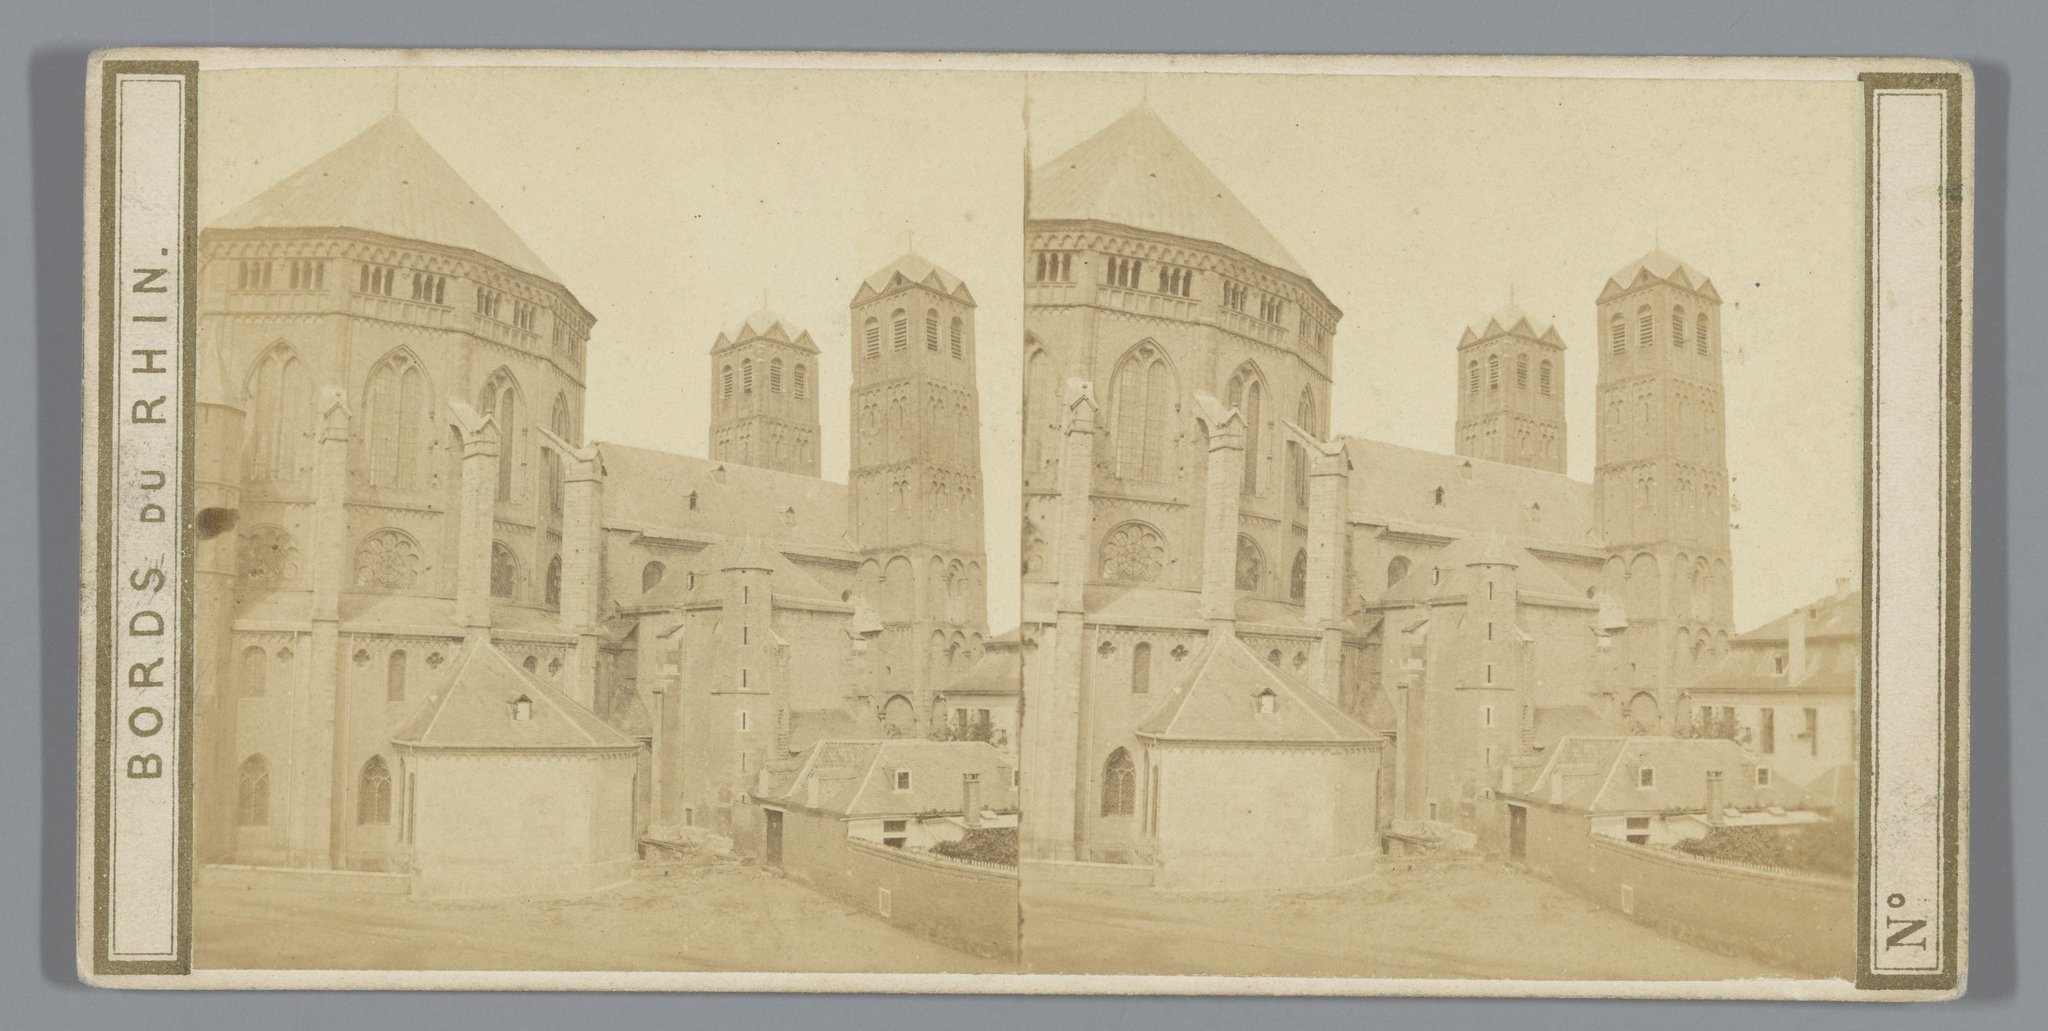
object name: stereograph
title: Bords du Rhin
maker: alexandre bertrand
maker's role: fotograaf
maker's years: 1822-1889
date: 1865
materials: cardboard, photographic support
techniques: albumen print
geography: cologne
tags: church (exterior), façade (of house or building)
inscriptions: number: ‘No 42’, inscription: ‘Eglise St Géreon a Aix-la-Chapelle, Prusse’